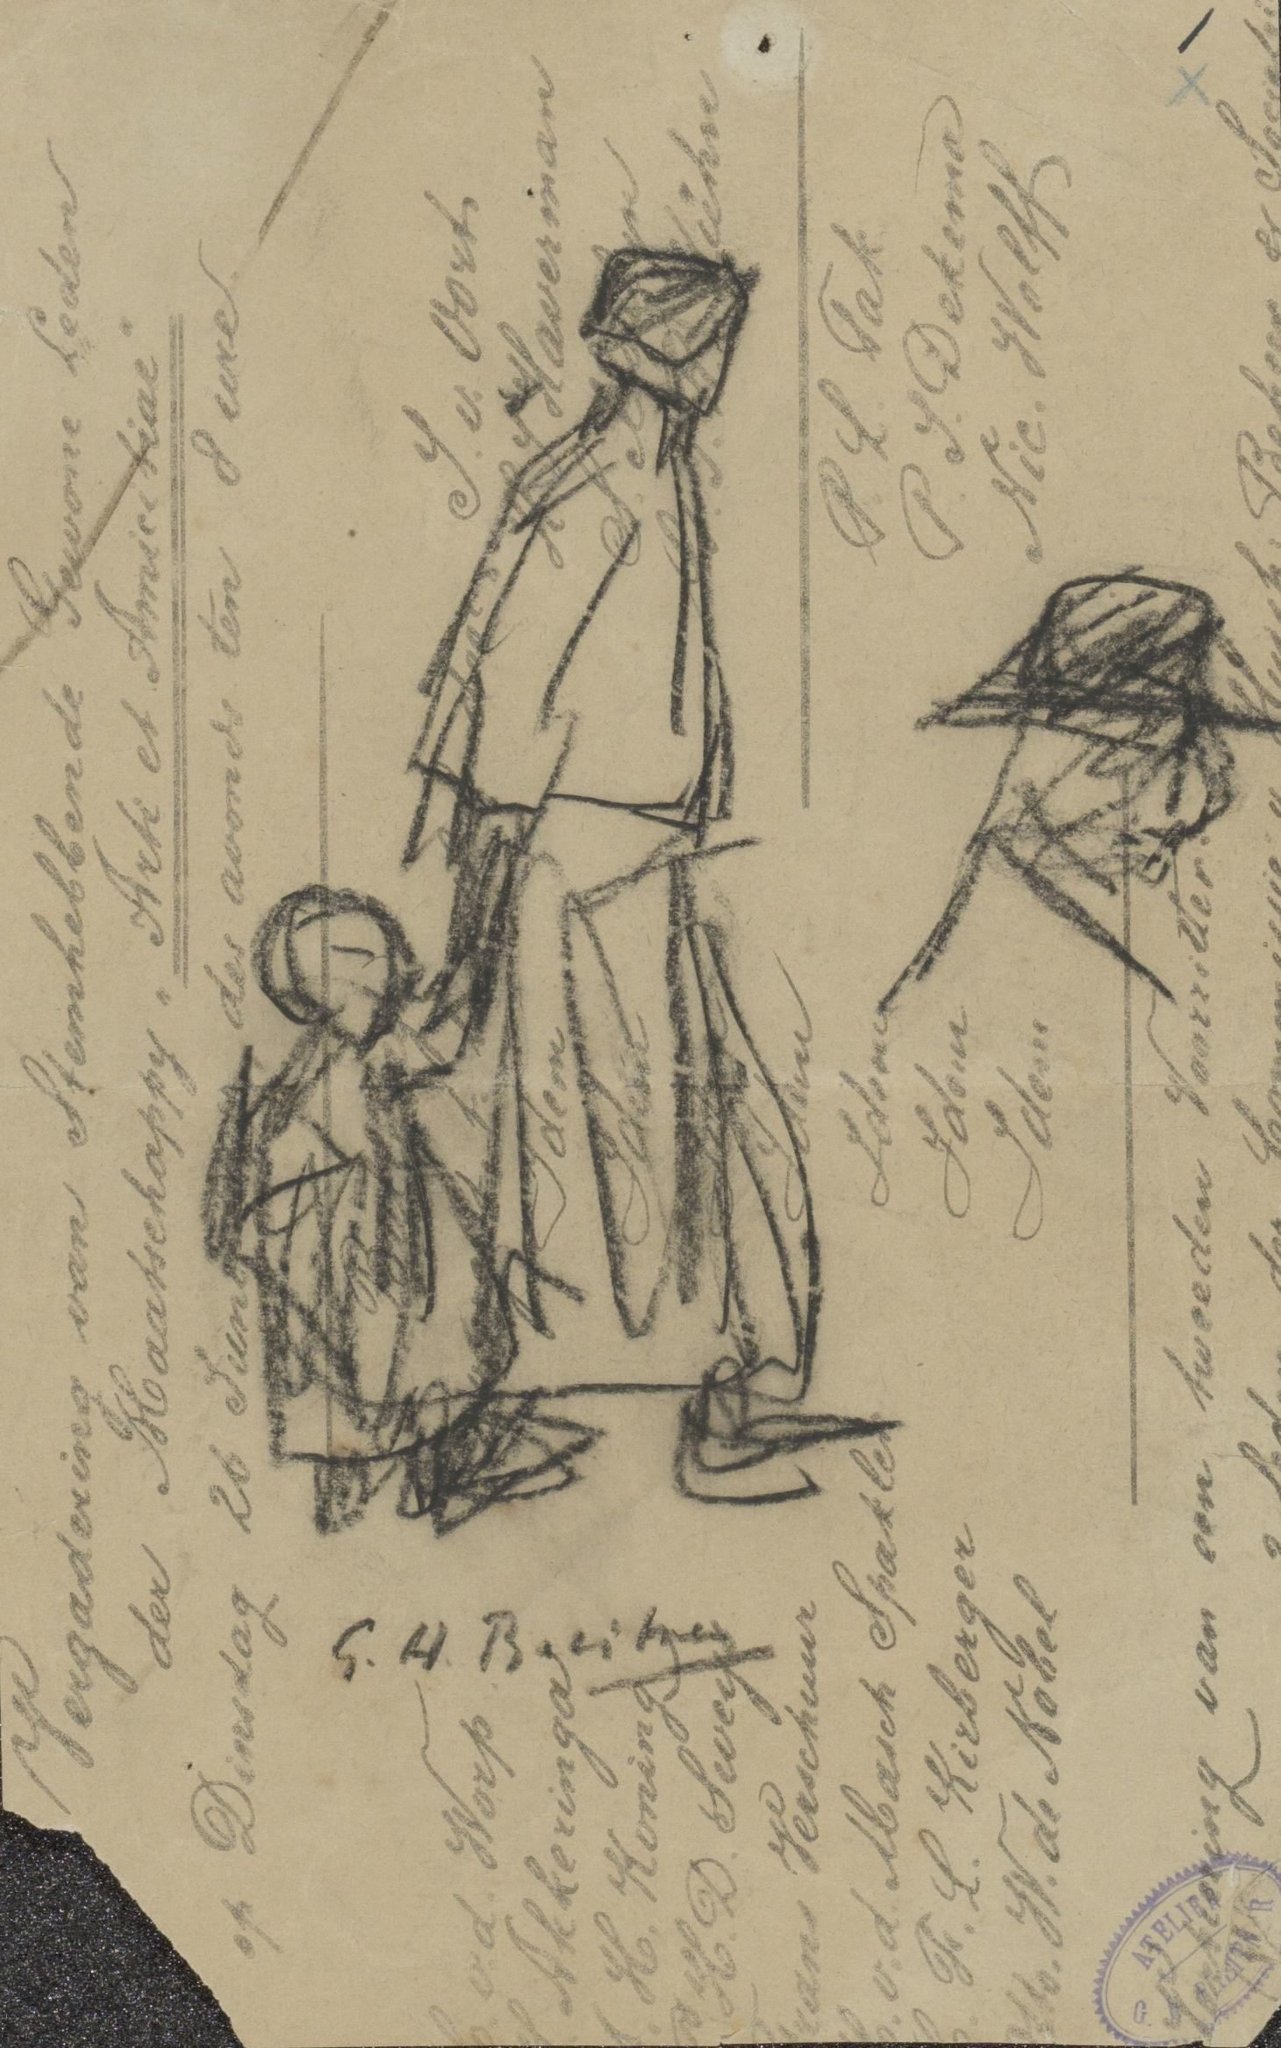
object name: drawing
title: Mannenhoofd met hoed en een vrouw met een kind aan de hand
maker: george hendrik breitner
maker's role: draughtsman, painter, print maker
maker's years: 1857-1923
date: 1886-1923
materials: chalk, paper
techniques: printing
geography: amsterdam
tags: head (human), head-gear: hat (+ men's clothes), mother and daughter(s) (family group)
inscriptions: signature: ‘G.H. Breitner’, annotation: ‘Vergadering van Stemhebbende Gewone Leden/ der Maatschappij ..Arti et Amicitiae"/ op Dinsdag 26 Juni voor des avonds ten 8 ure./ [persoonsnamen]’, workshop stamp: Lugt 291d